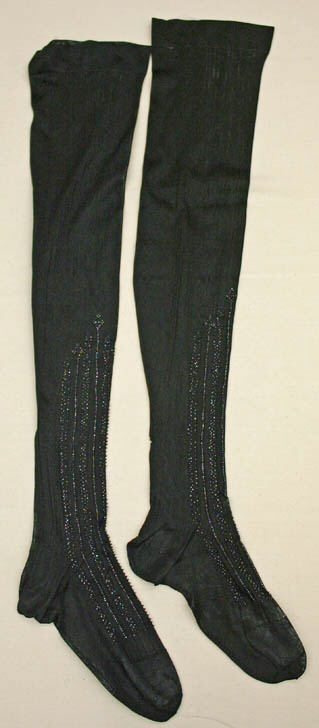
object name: stocking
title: Stockings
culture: french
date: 1900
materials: glass, silk